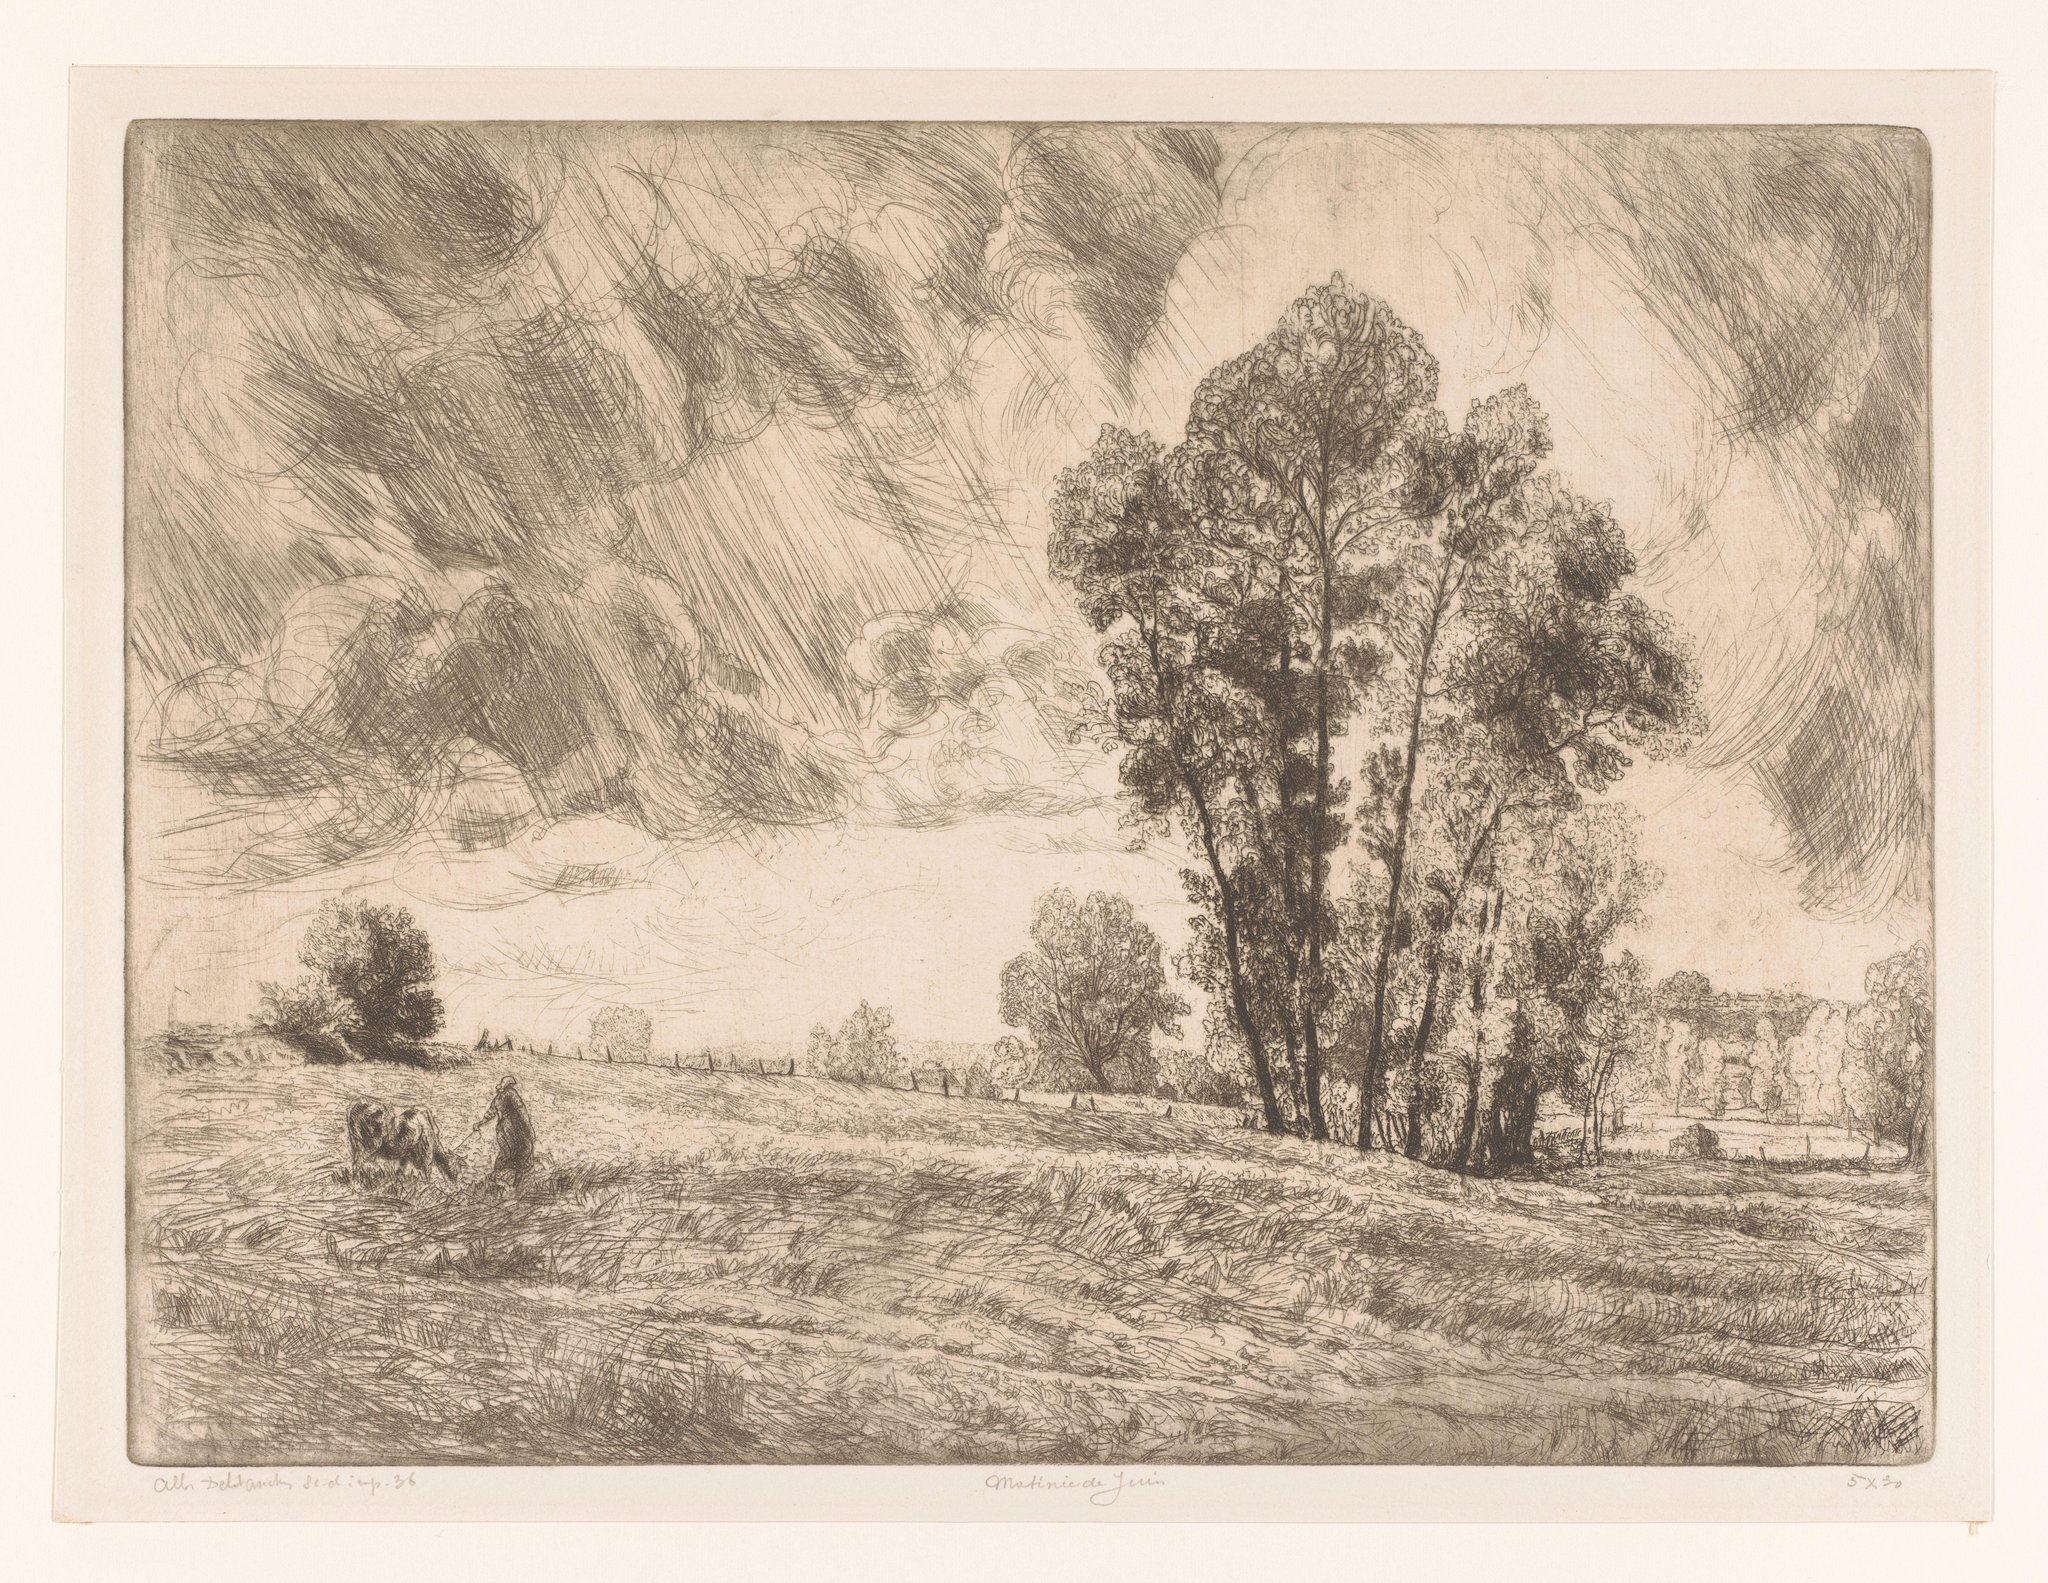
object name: print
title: Regenbuien boven een weidelandschap met boerin en koe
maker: albert delstanche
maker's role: print maker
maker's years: 1870-1941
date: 1936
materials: paper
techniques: etching, intaglio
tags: cow, meadow, pasture, rain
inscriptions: inscription: ‘Delstanche Albert, Brabantsch landschap [...] Ohain’, collector's mark: Lugt 2228, collector's mark: Lugt 2760, inscription: ‘Alb. Delstanche sc. et imp. 36 / Matinée de Juin’